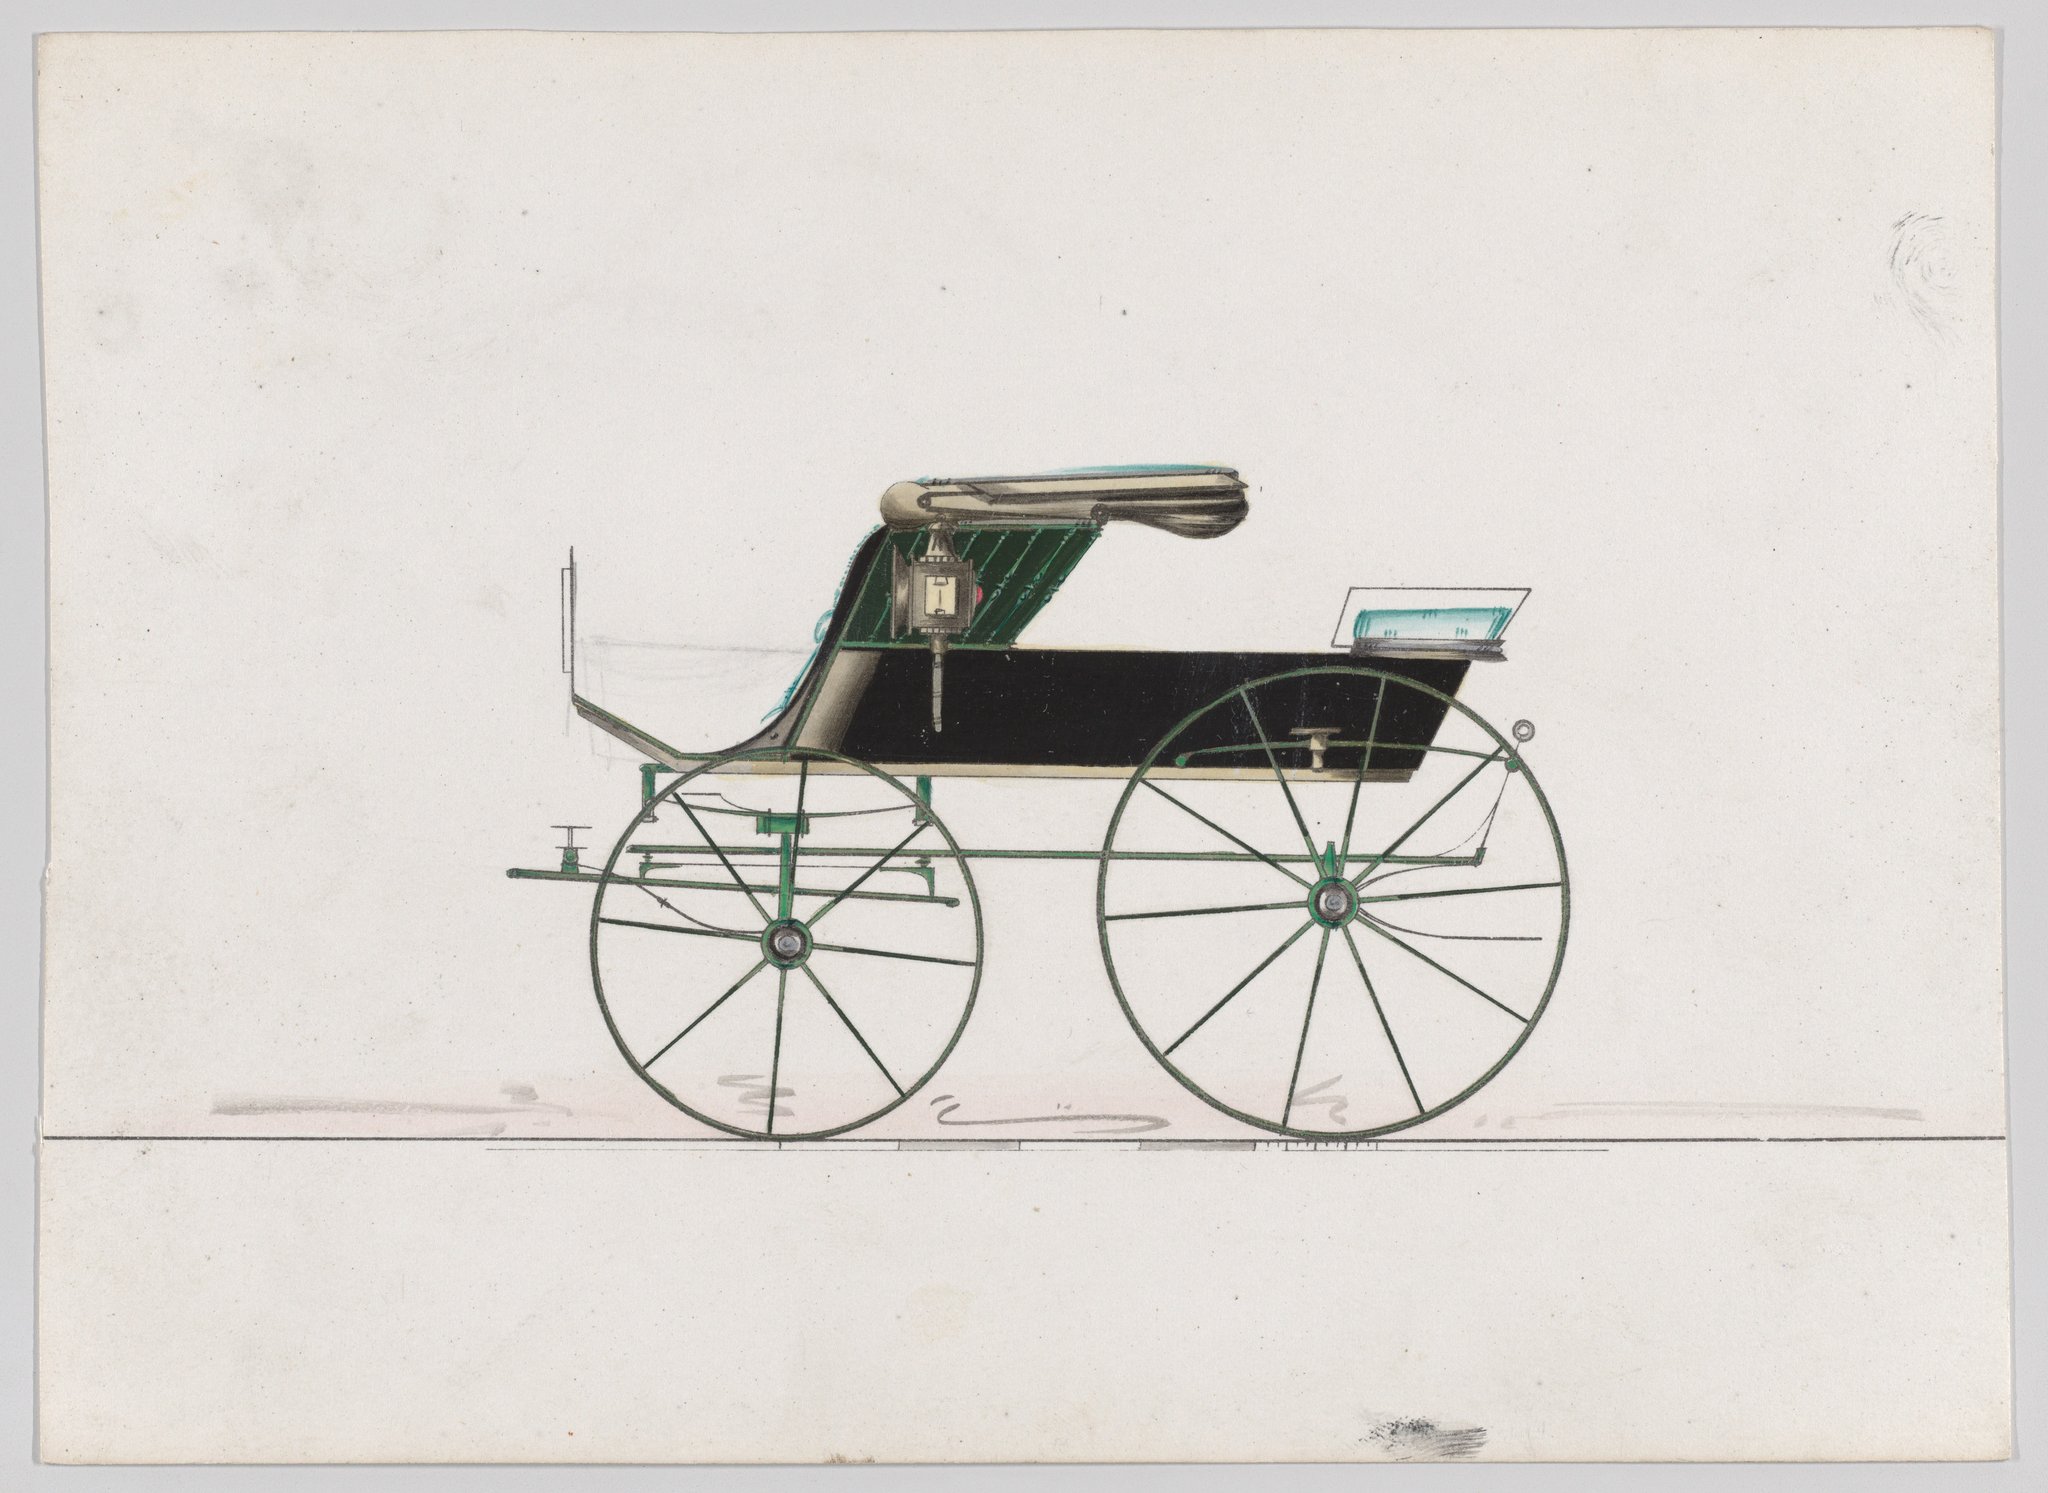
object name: drawing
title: Design for Stanhope Phaeton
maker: brewster & co.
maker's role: manufacturer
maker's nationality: american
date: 1850-1870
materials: gouache, gum arabic, ink, watercolor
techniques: pen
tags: carriages